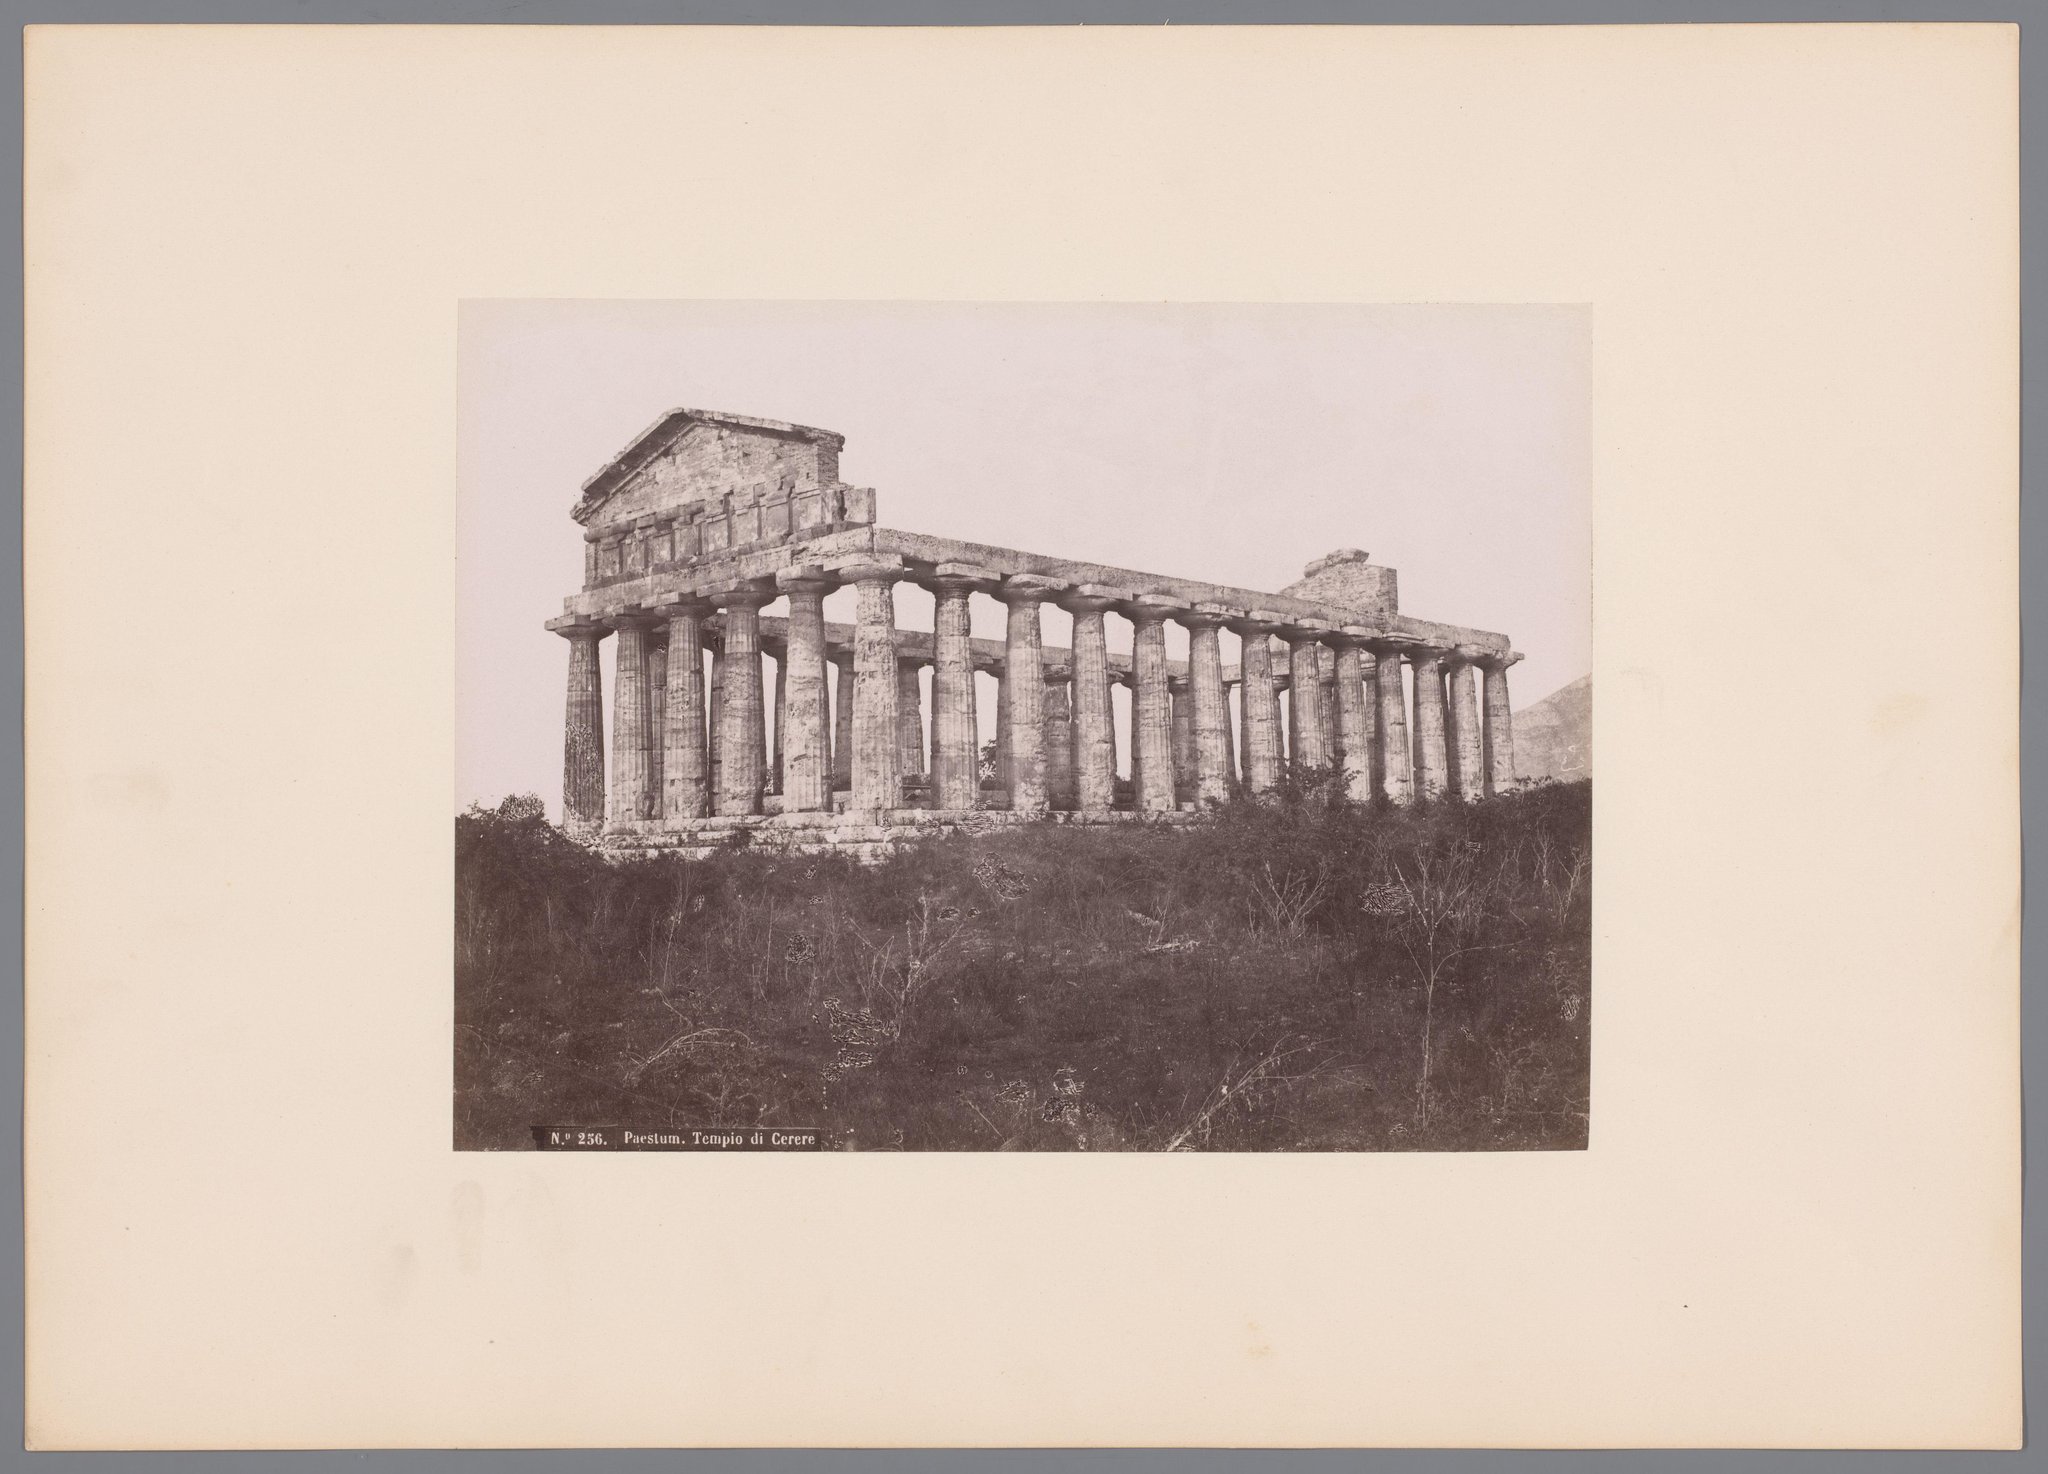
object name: photograph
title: Tempel van Athena in Paestum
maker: roberto rive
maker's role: fotograaf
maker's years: 1825-1868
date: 1860-1889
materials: cardboard, paper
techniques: albumen print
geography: paestum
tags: ruin of a building ~ architecture, temple, shrine ~ greek religion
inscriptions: inscription: ‘Rive (t)’, number: ‘No. 256.’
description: Men heeft lange tijd ten onrechte aangenomen dat dit de Tempel van Ceres is geweest.